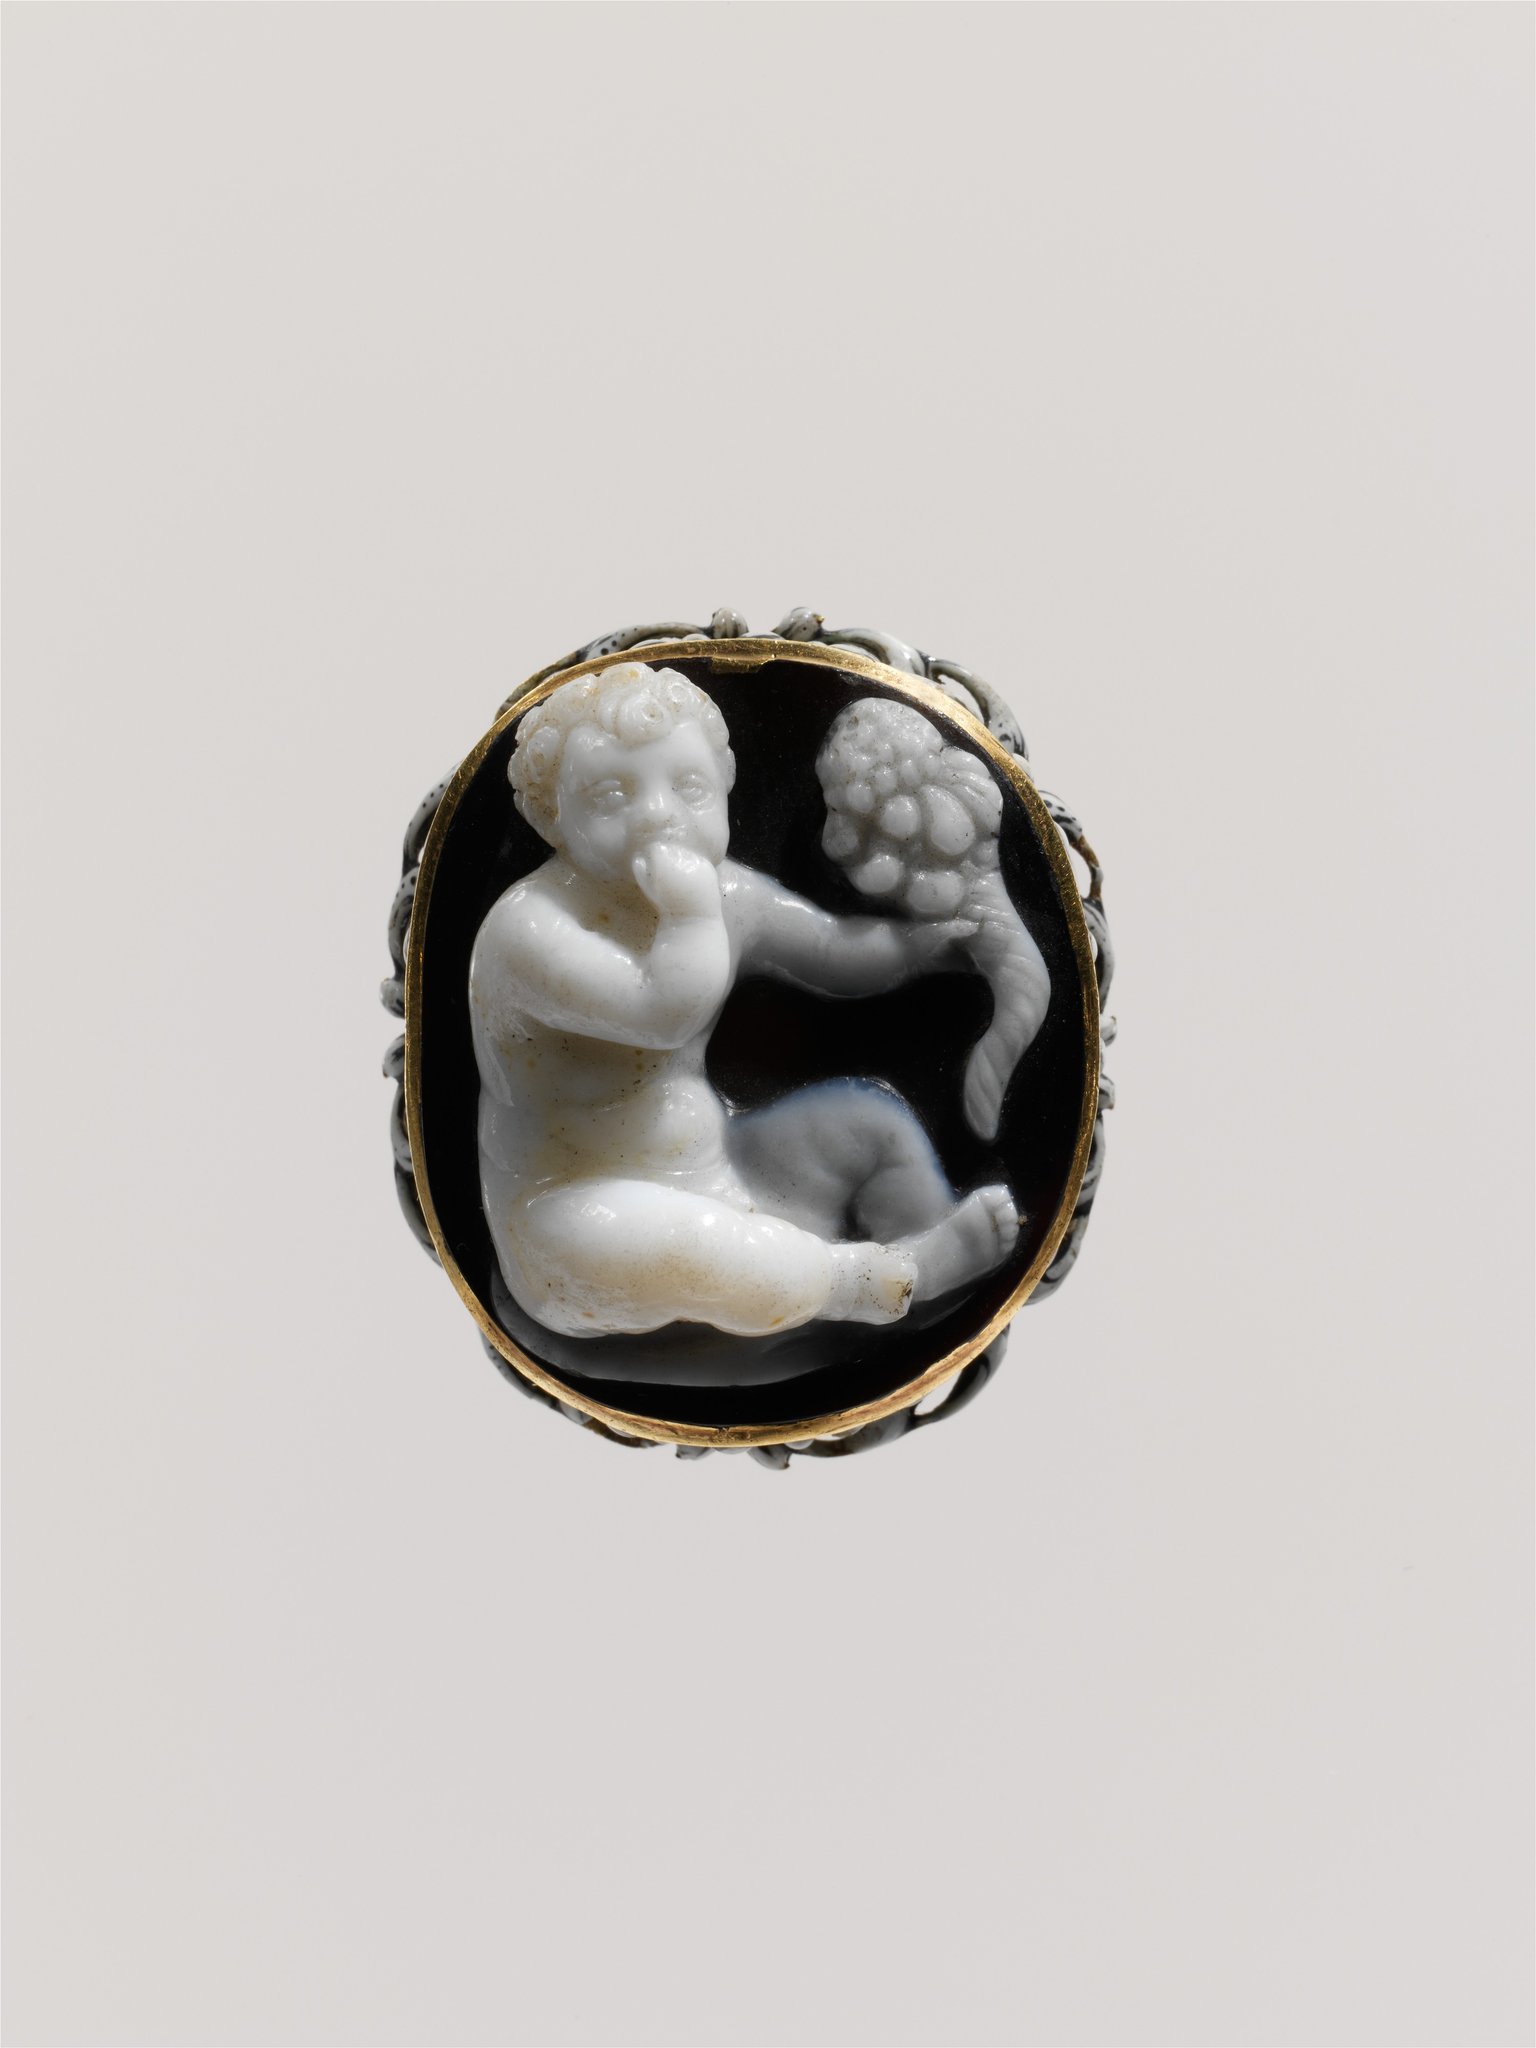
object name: cameo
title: Sardonyx cameo of the infant Harpokrates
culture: greek or roman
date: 100 BCE-100 CE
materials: enamel, gold, gemstone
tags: infants